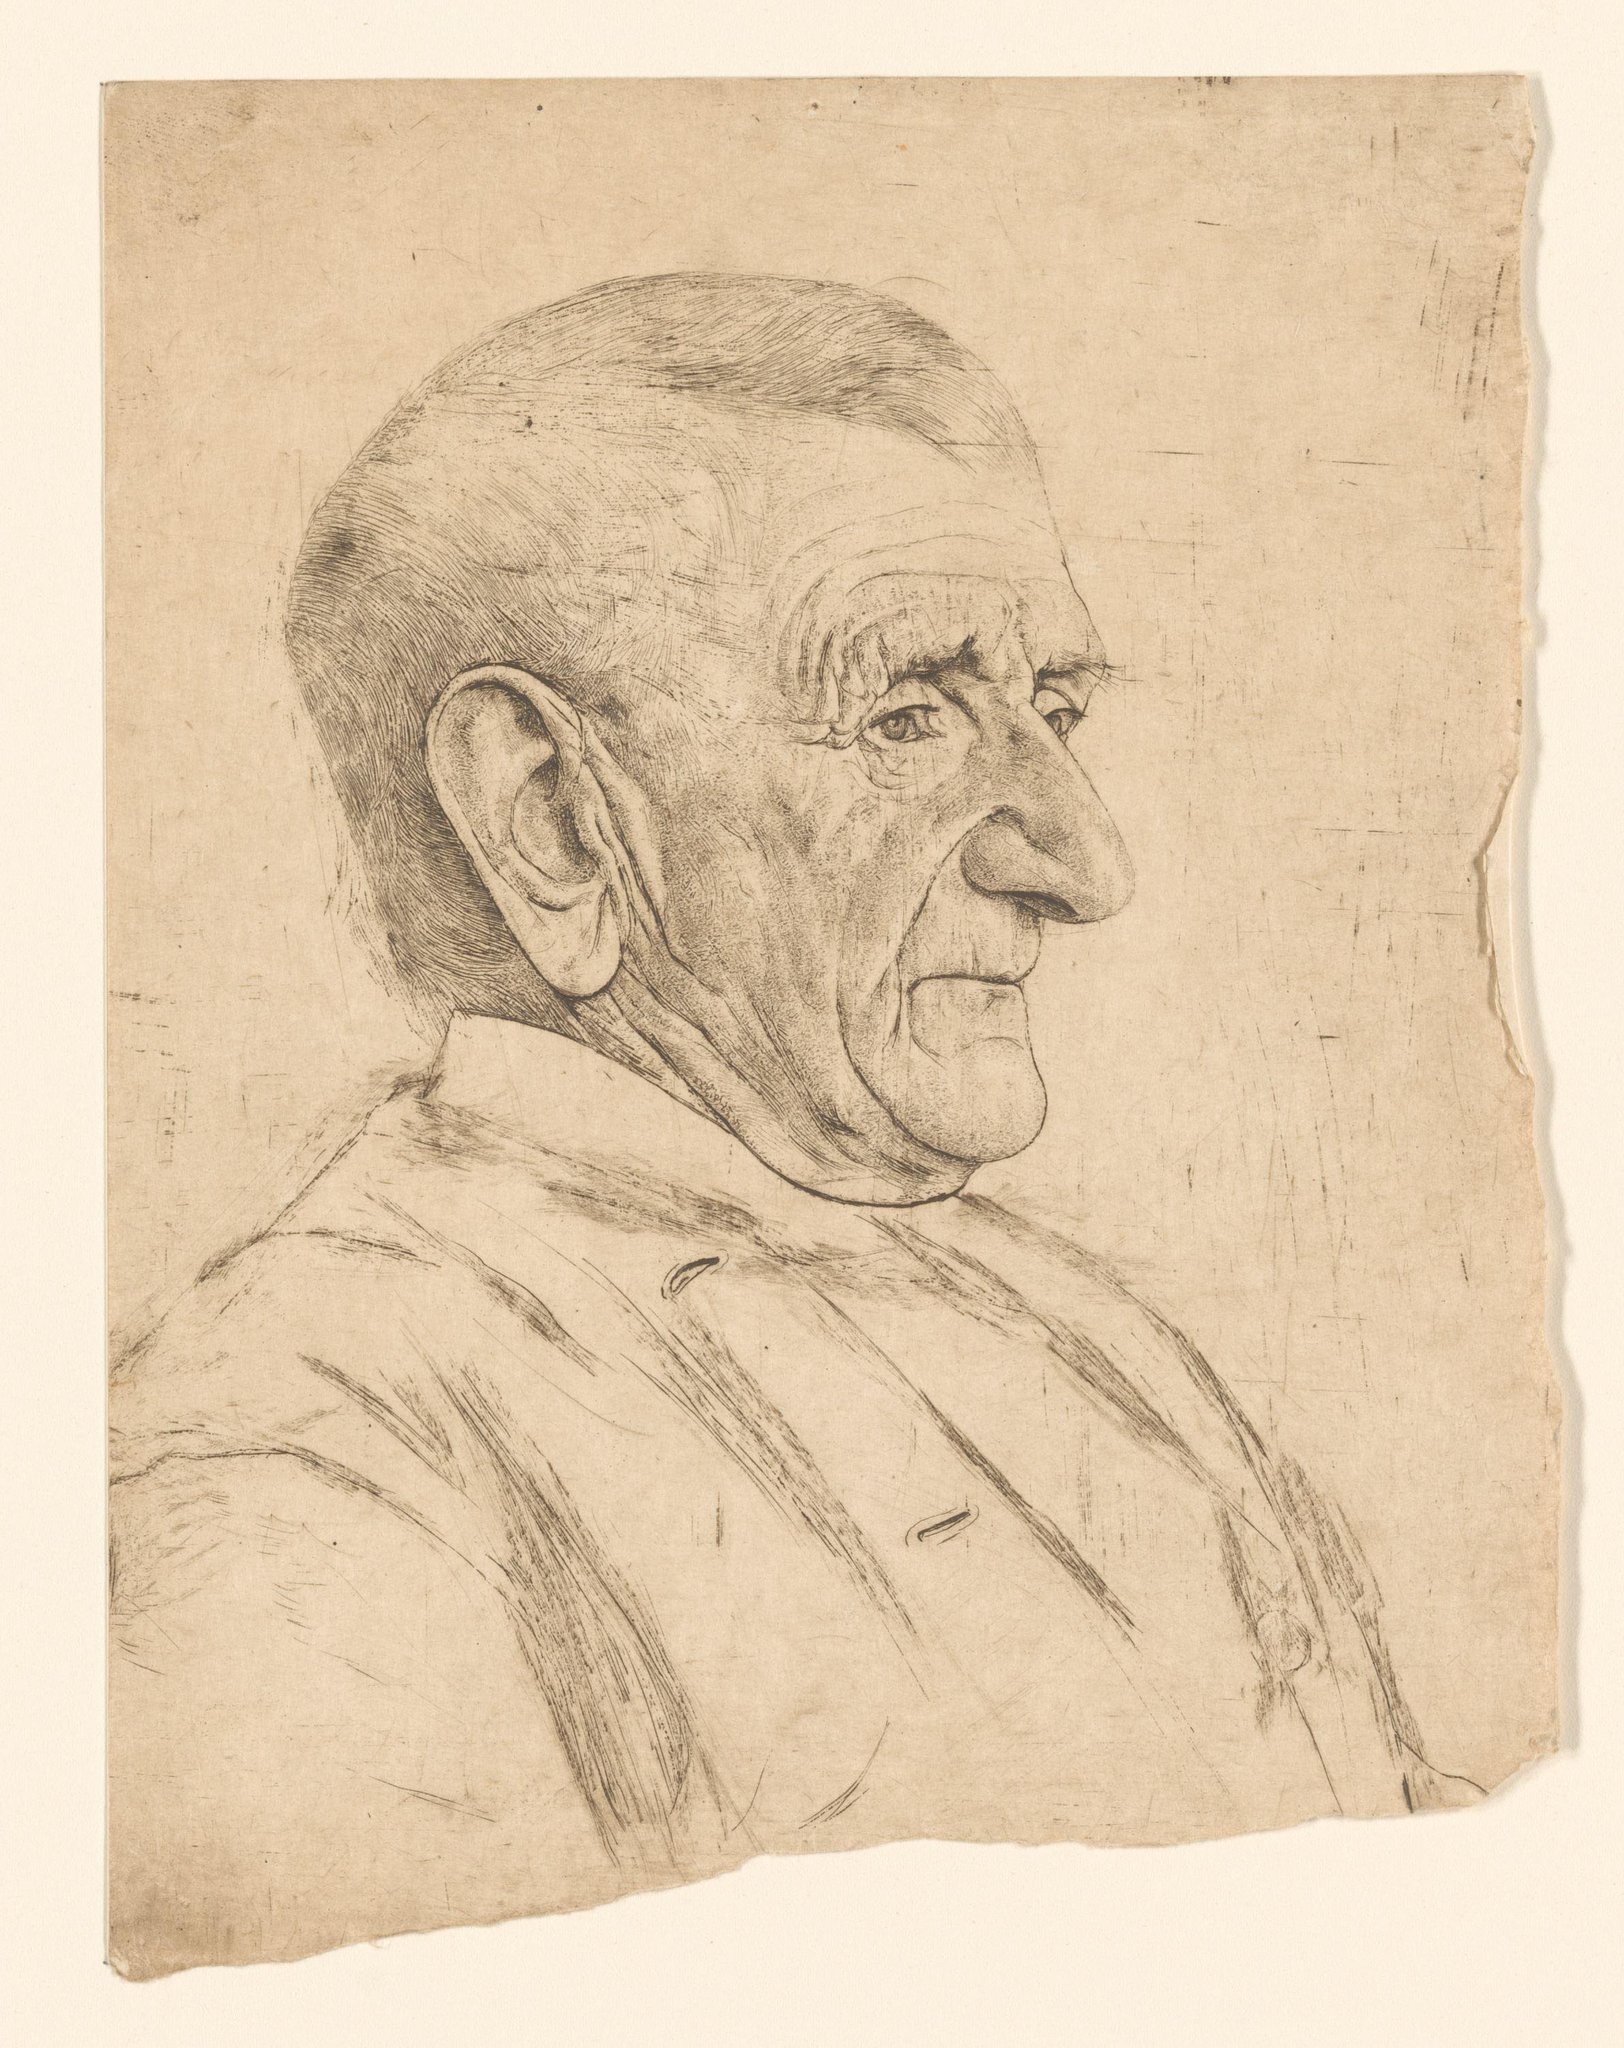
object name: print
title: Portret van Jan Schaap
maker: jan veth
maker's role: designer, draughtsman, painter, print maker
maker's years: 1864-1925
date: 1891-1892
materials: paper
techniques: drypoint, etching, intaglio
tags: historical persons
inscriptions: collector's mark: Lugt 2228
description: Prent verscheen in 1891 als onderdeel van de jaarlijkse uitgave van de 'Portefeuille der Nederlandsche Etsclub'.